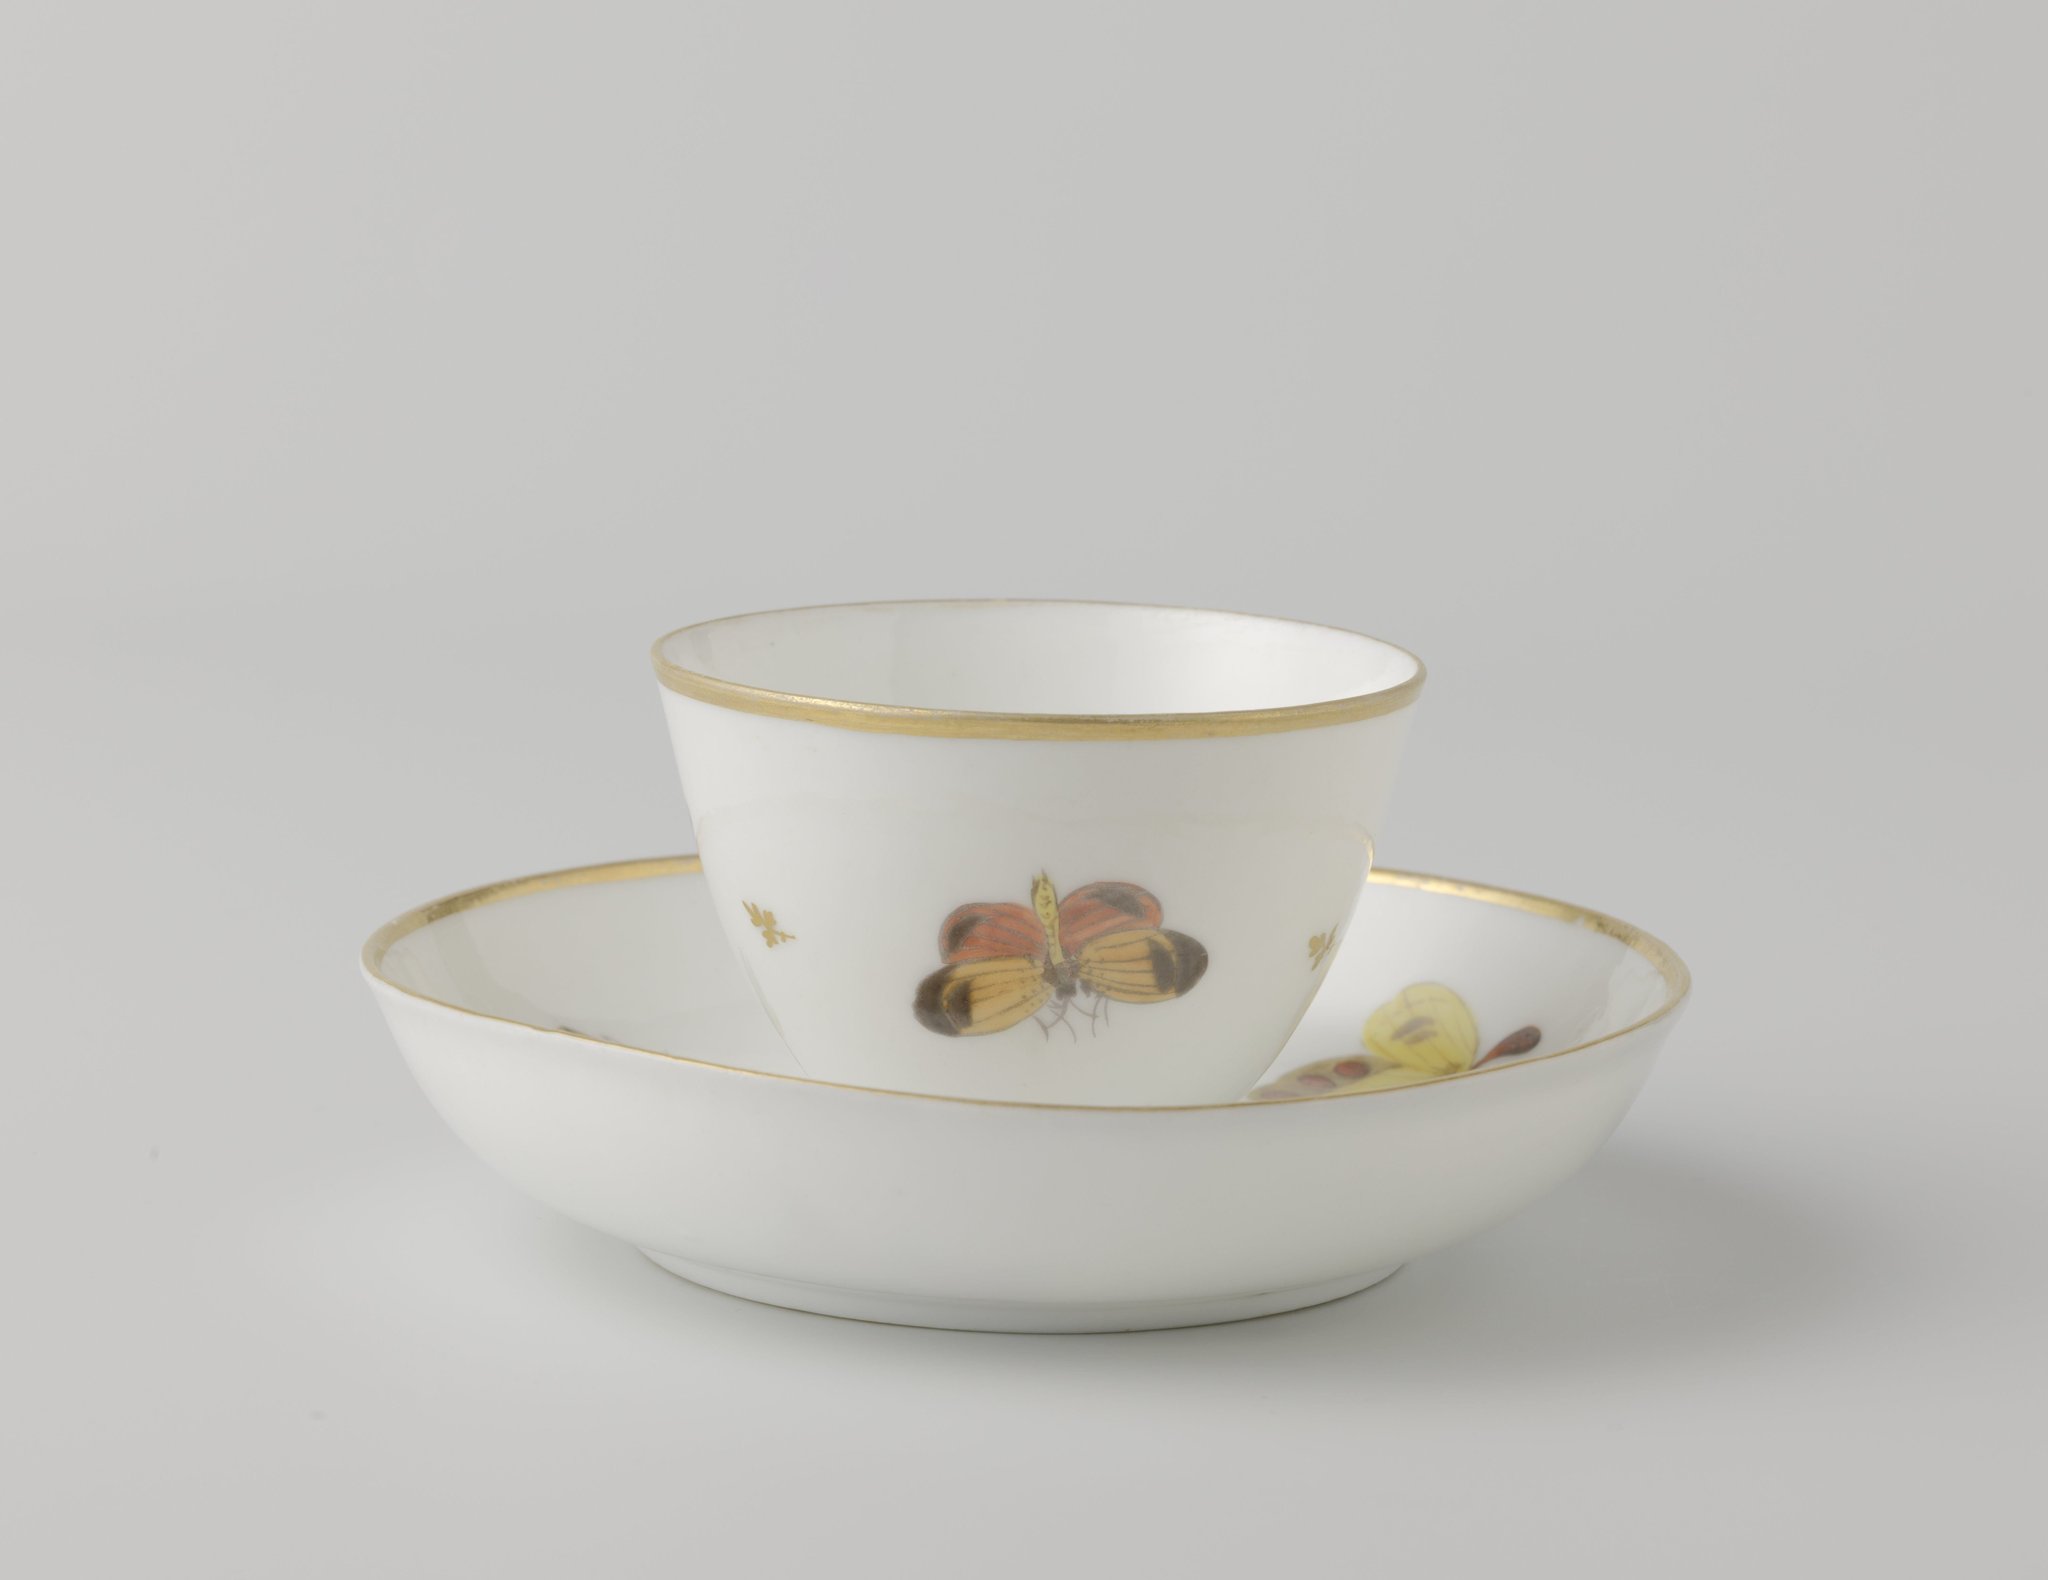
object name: kop en schotel, kop en schotel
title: Kop en schotel beschilderd met vlinders en libellen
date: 1784-1809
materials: porcelain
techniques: painted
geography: ouder-amstel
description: Cup and saucer. Porcelain. Nieuwer-Amstel, c. 1809 - 1814. Factory of Nicolaas Gerard Dommer. Given by Mesdames J.J. and E.S. Kramer, 1942.